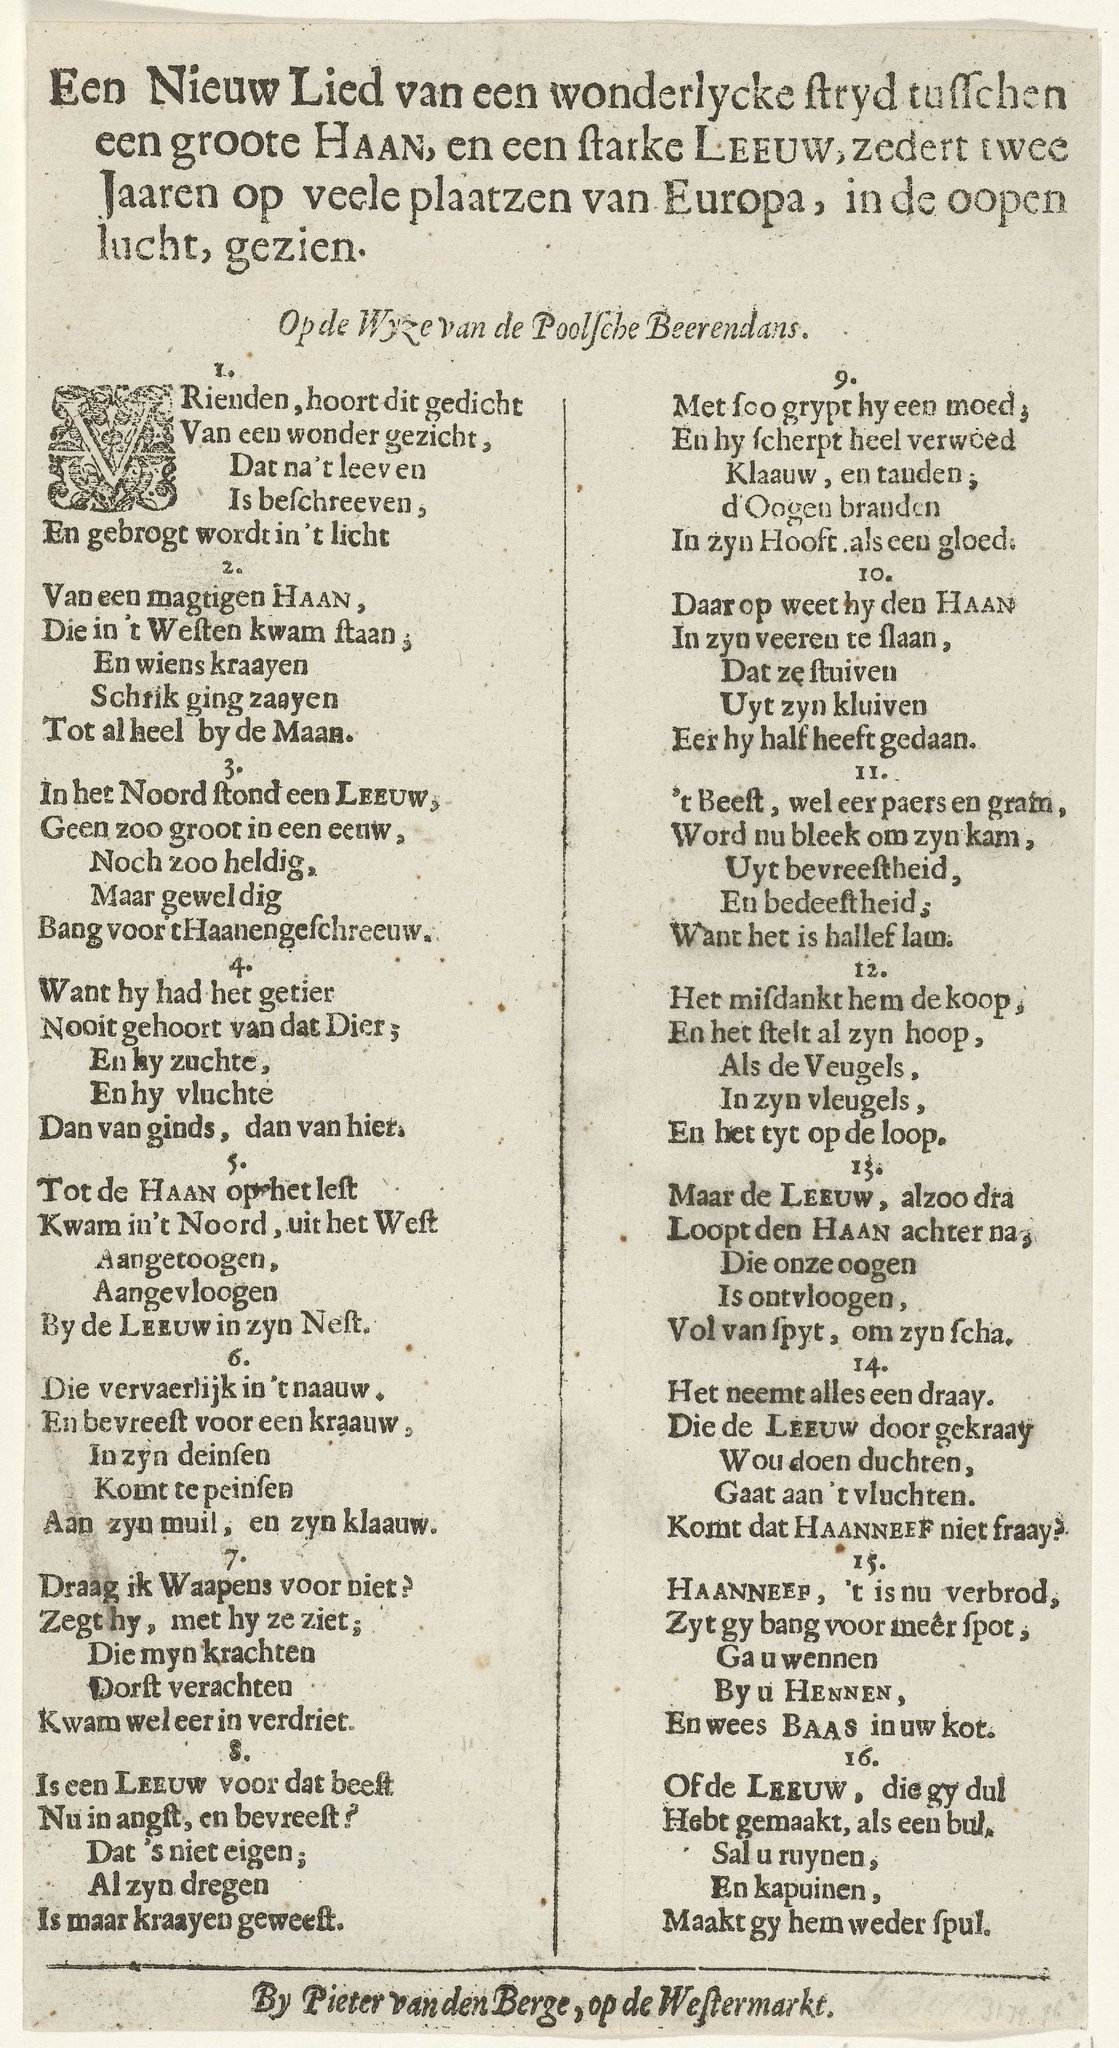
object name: text sheet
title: Een Nieuw Lied van een wonderlycke stryd tusschen een groote Haan, en een starke Leeuw, zedert twee Jaaren op veele plaatzen van Europa, in de oopen lucht, gezien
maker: pieter van den berge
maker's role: draughtsman, print maker, printer, publisher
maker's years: 1659-1737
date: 1708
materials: paper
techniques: letterpress printing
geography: amsterdam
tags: spaanse successieoorlog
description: Tekstblad met een lied over de strijd tussen de Franse haan en de Nederlandse leeuw, 1708S. Lied van 16 verzen in het Nederlands. Toegevoegd aan de reeks getiteld Palmhof der Bondgenooten met 9 spotprenten op de Fransen en bondgenoten uit het jaar 1708.